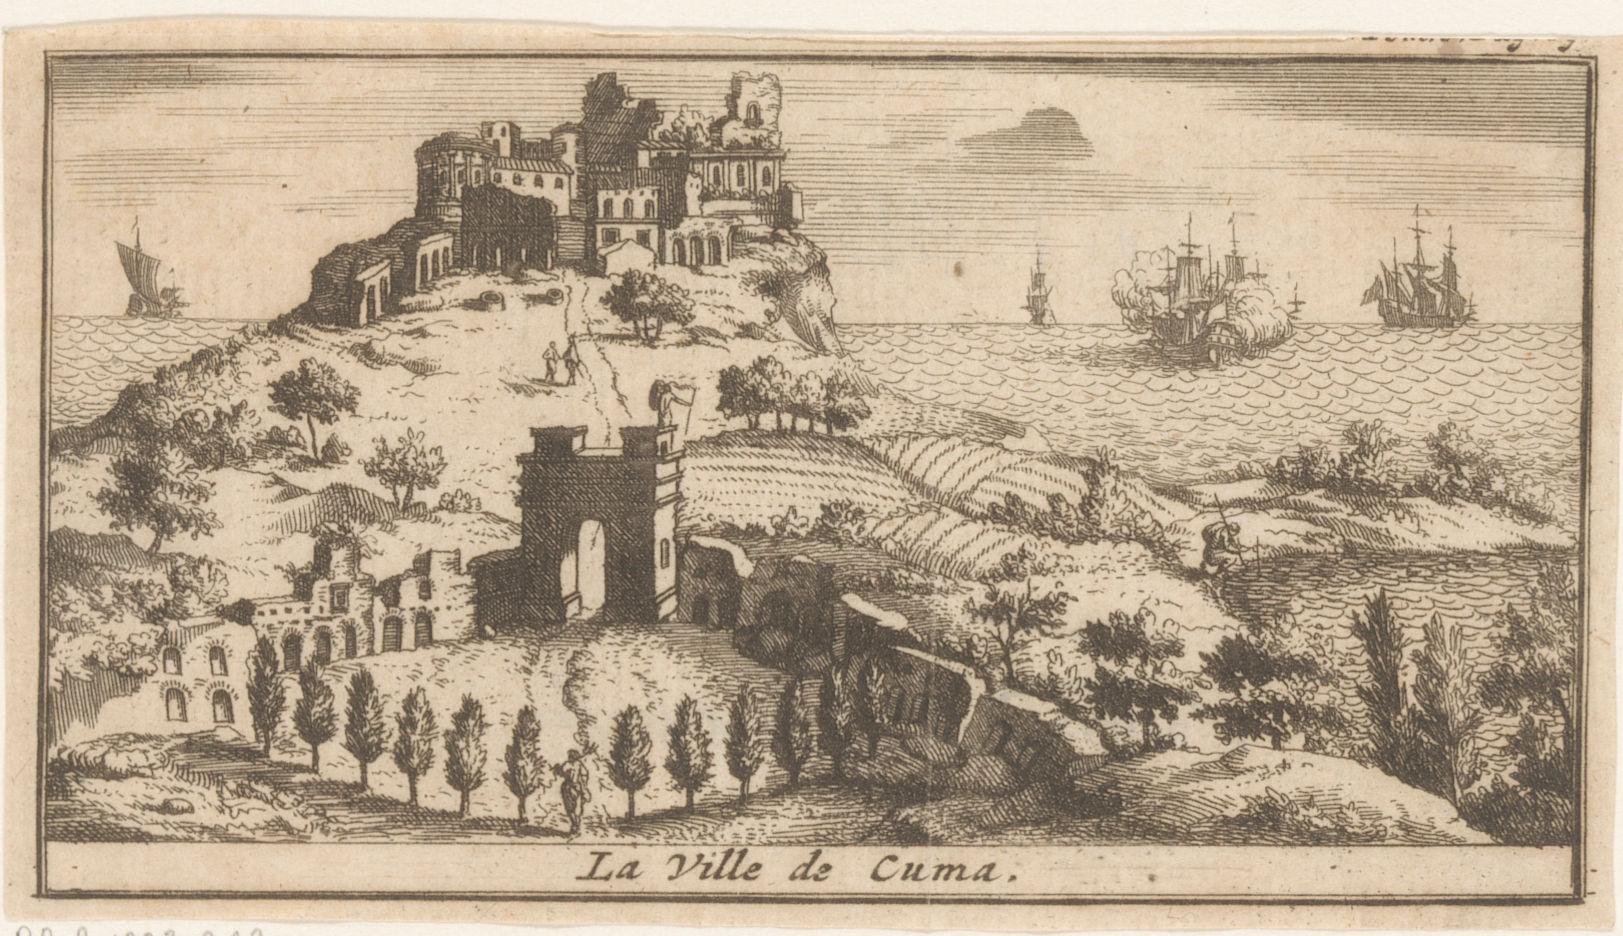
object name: print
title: Cumae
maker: pieter van der aa (i)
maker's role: printer, publisher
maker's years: 1659-1733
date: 1682-1730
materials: paper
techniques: etching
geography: leiden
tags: gulf, bay, sailing-ship, sailing-boat, landscapes, landscape with ruins, coast, cuma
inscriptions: collector's mark: Lugt 2228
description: Gezicht op de ruïnes van de stad Cumae, op een heuvel aan de Italiaanse westkust. Op de achtergrond varen zeilschepen op zee.